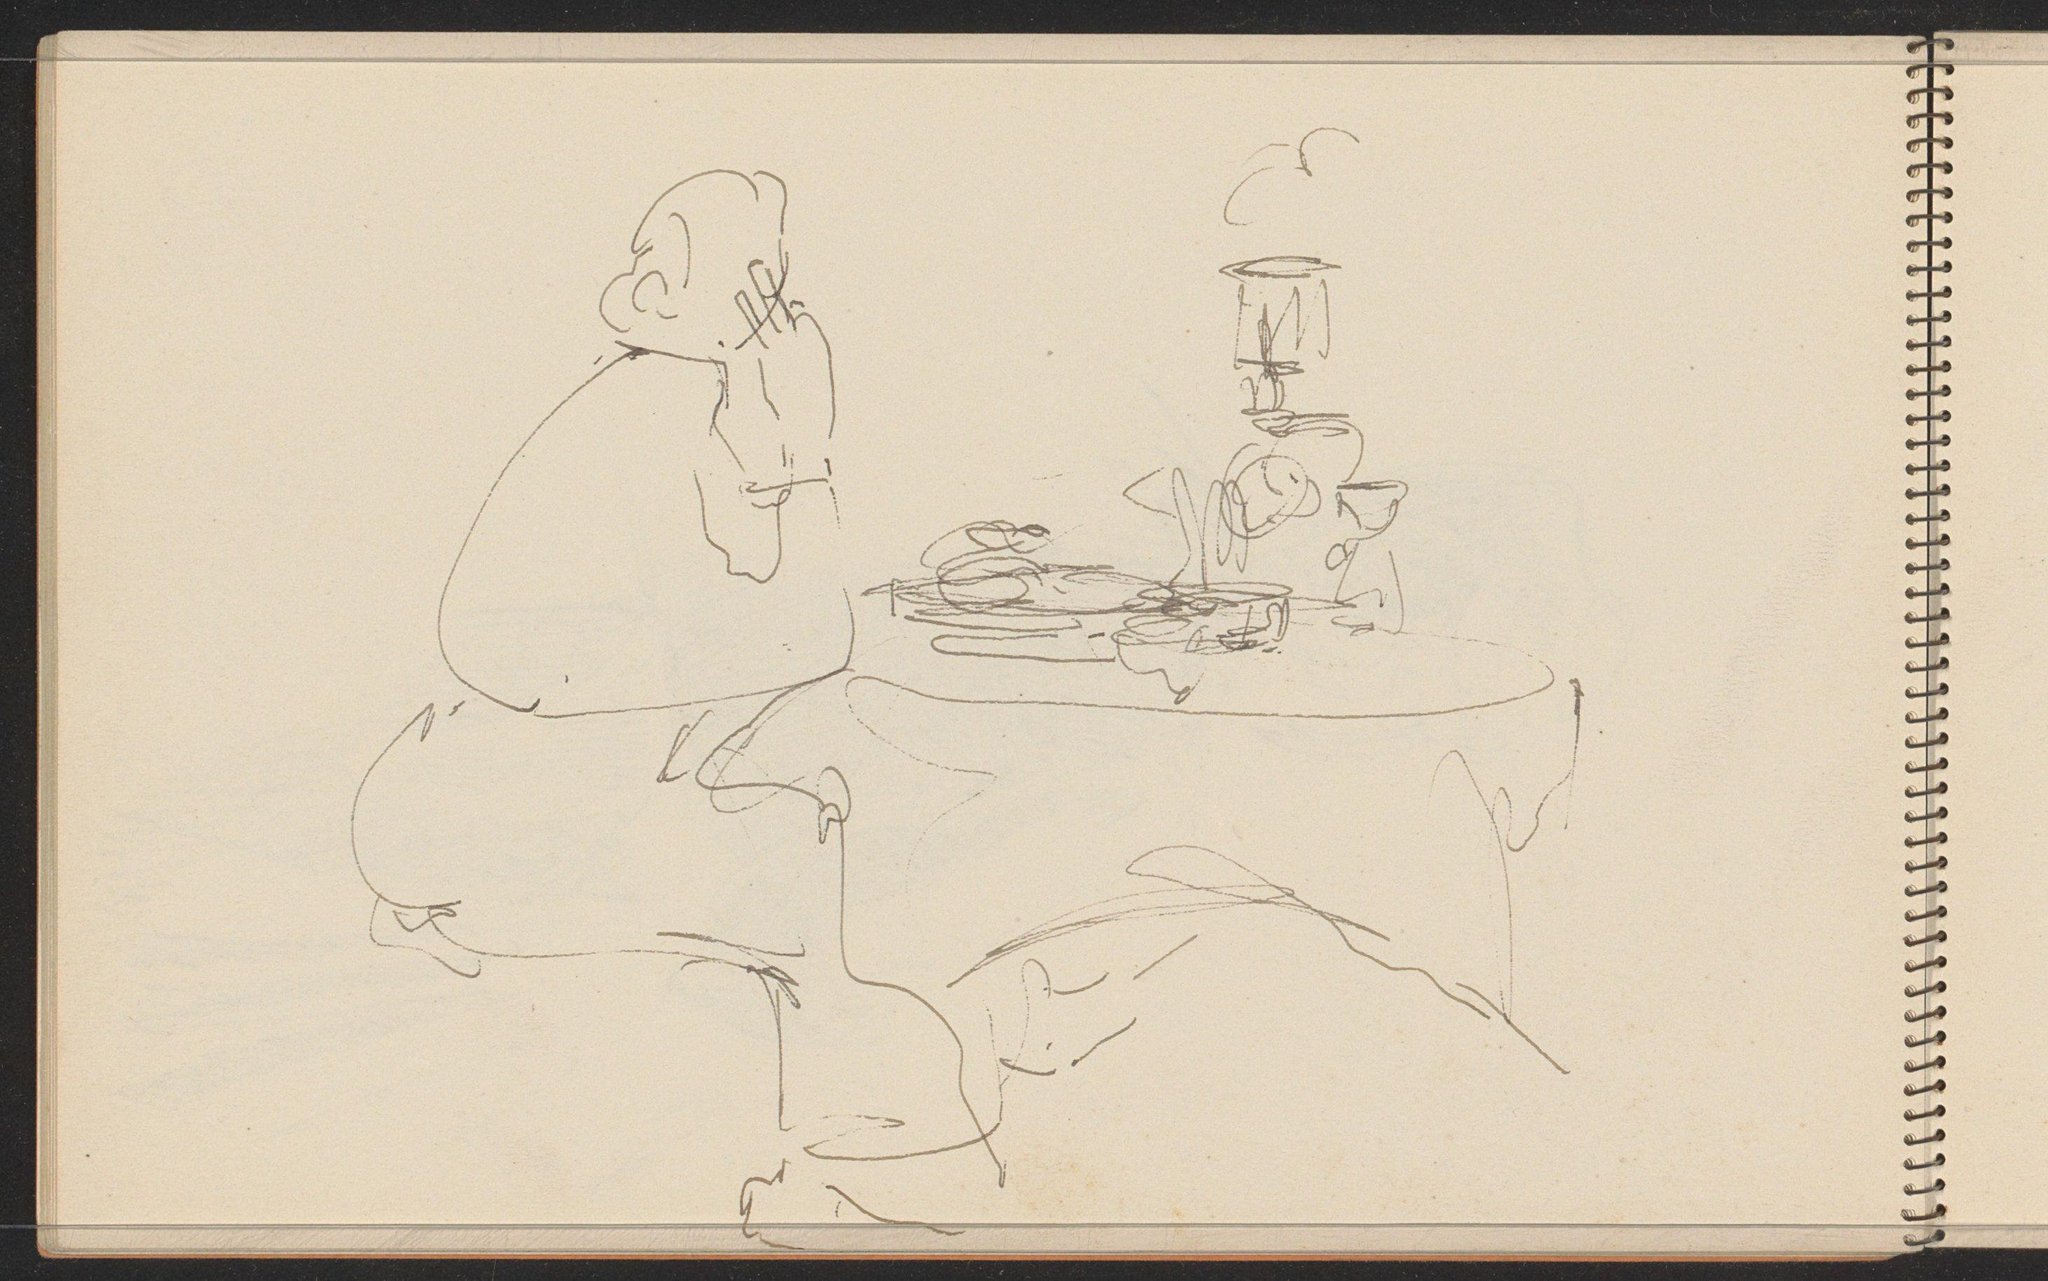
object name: sketchbook leaf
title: Vrouw, vermoedelijk Joanna Lion Cachet-Cordes, zittend aan een gedekte tafel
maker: carel adolph lion cachet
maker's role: draughtsman, print maker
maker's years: 1864-1945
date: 1935-1940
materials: ink, paper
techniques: pen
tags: sitting figure (+ female (human being) (not to be used where -aa- is prescribed)), laid table: table-ware, table-decoration, etc.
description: De vrouw leunt met haar rechter elleboog op de tafel. Blad 7 verso uit een schetsboek met 25 bladen.